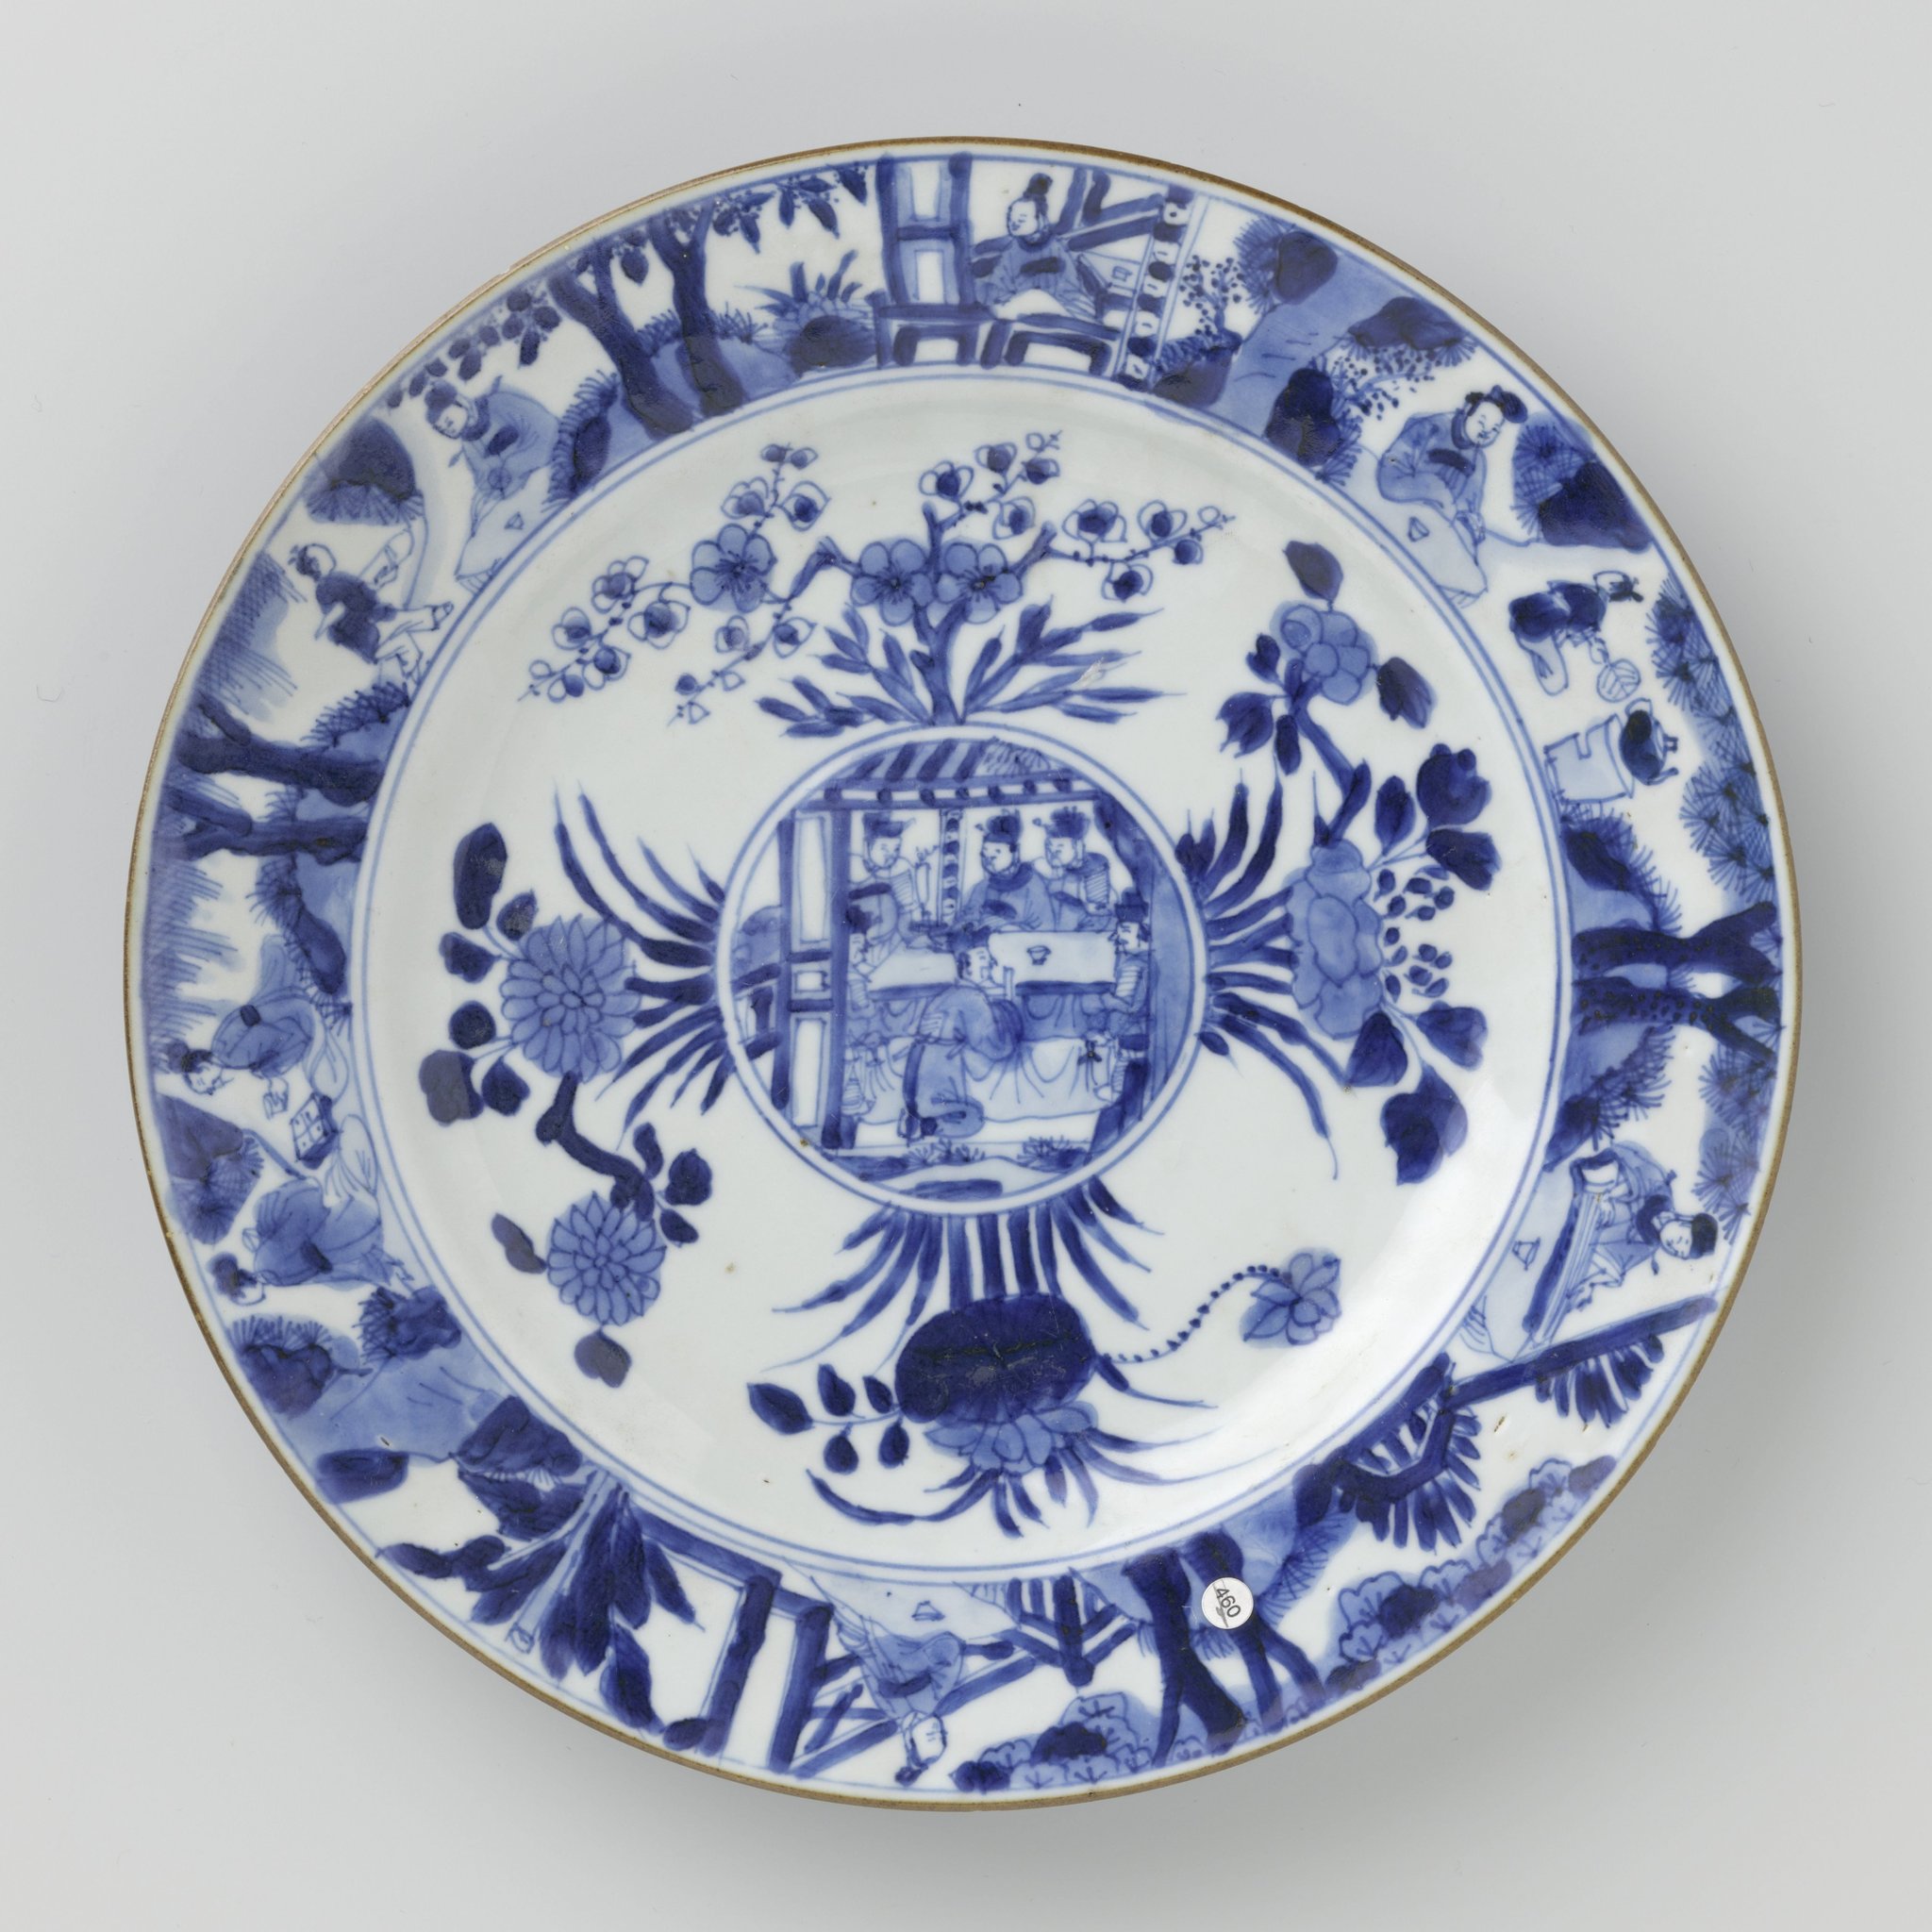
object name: plate dish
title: Plate with flower sprays and figures in an interior and in a landscape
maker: Anonymous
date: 1700-1724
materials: cobalt, glaze, paint, porcelain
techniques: firing, turning, vitrification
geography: china